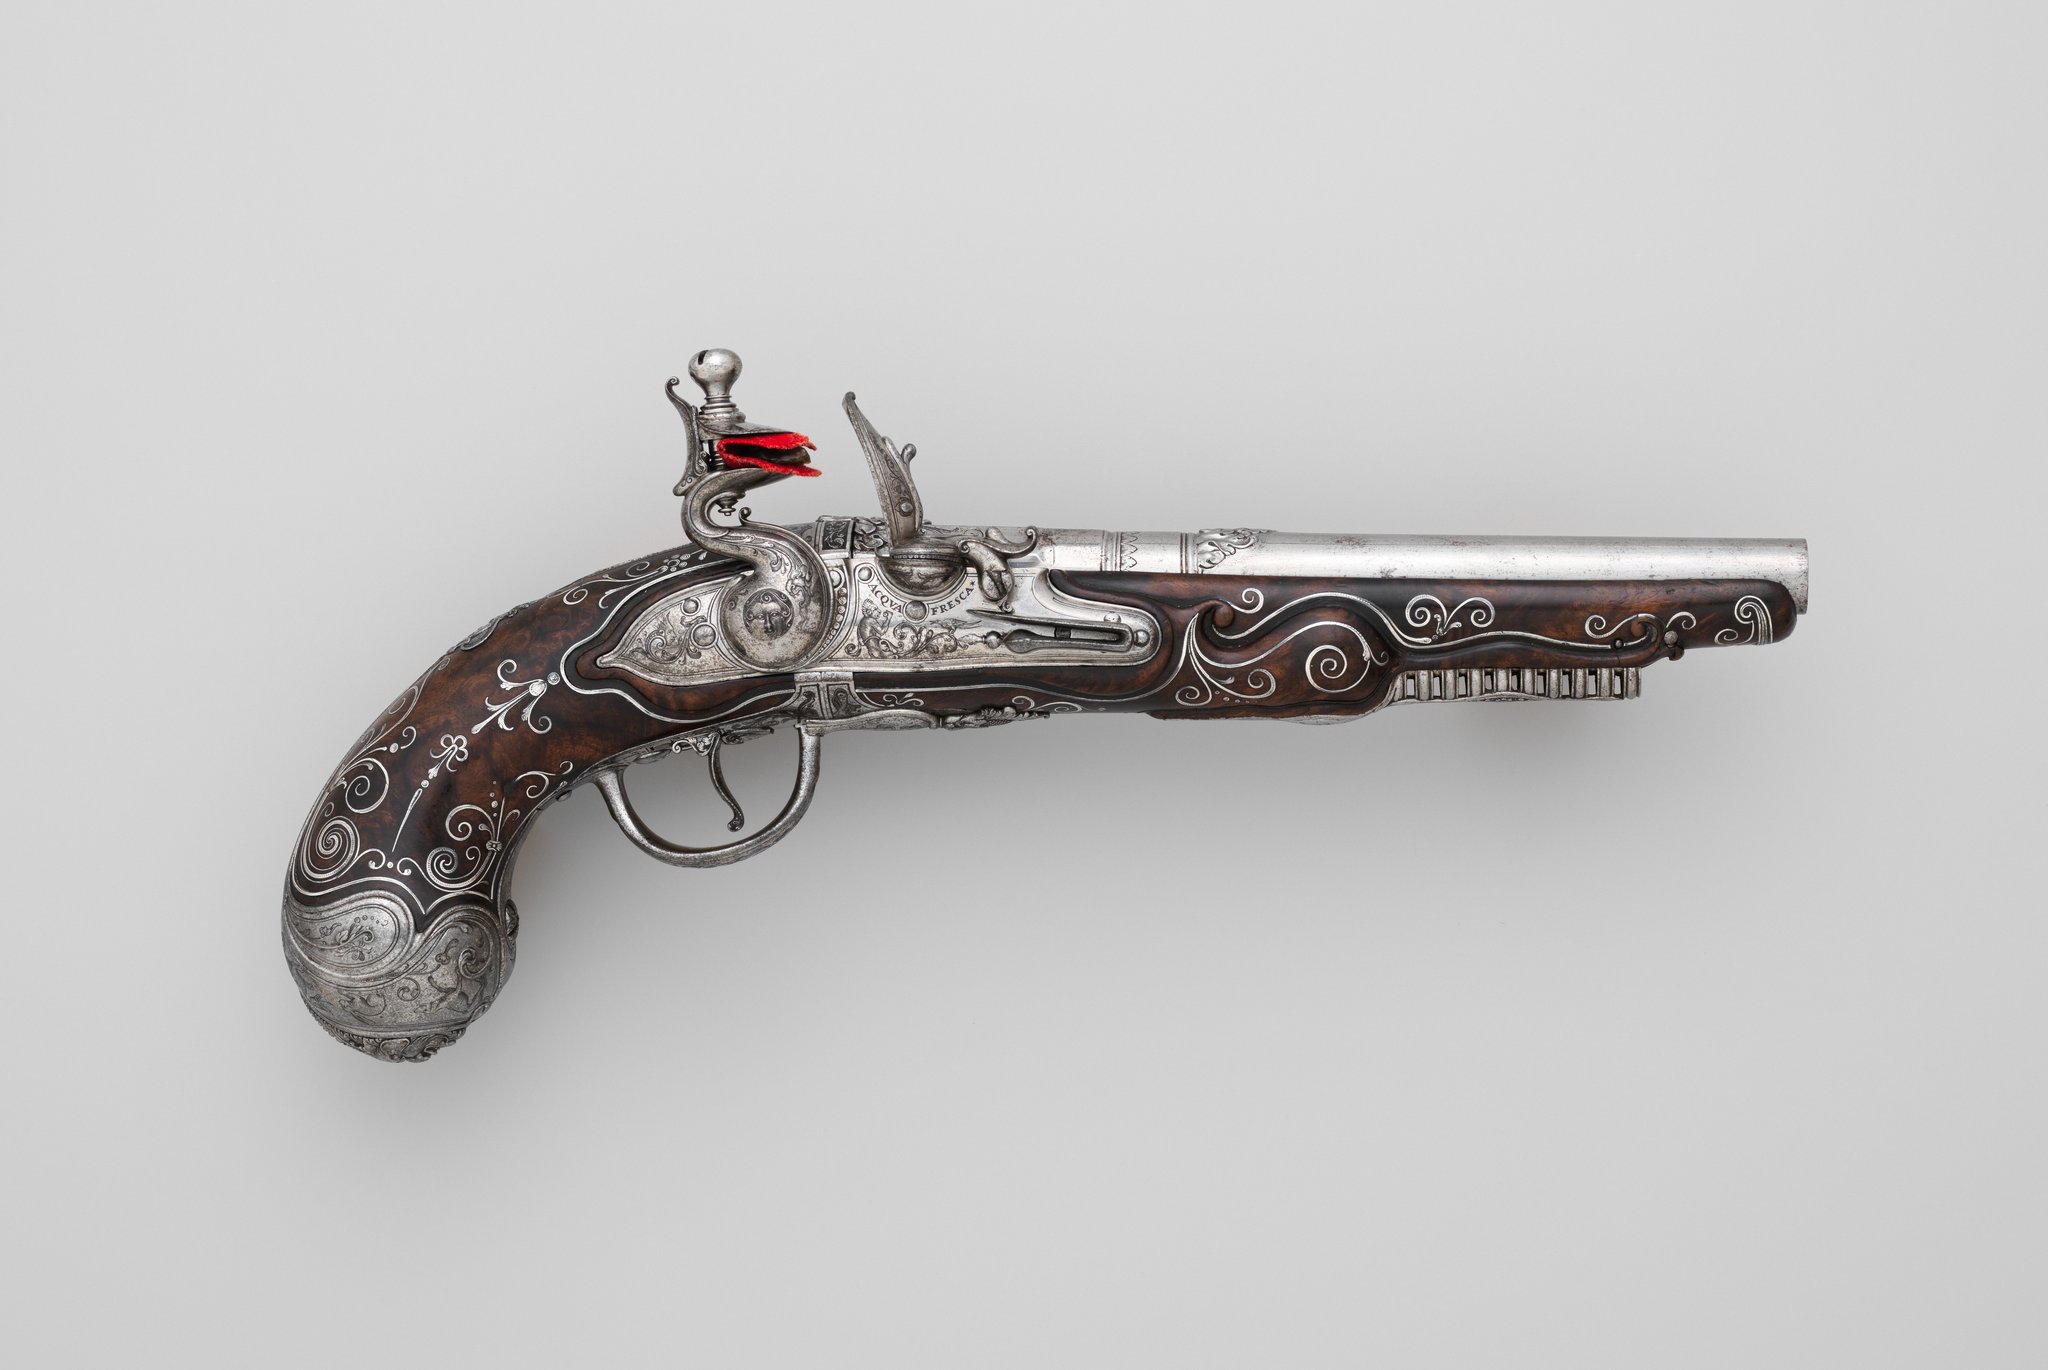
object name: combination flintlock pistol and concealed dagger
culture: italian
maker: matteo cecchi, called acquafresca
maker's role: gunsmith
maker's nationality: italian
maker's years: 1651-1738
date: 1690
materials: silver, steel, wood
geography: italy